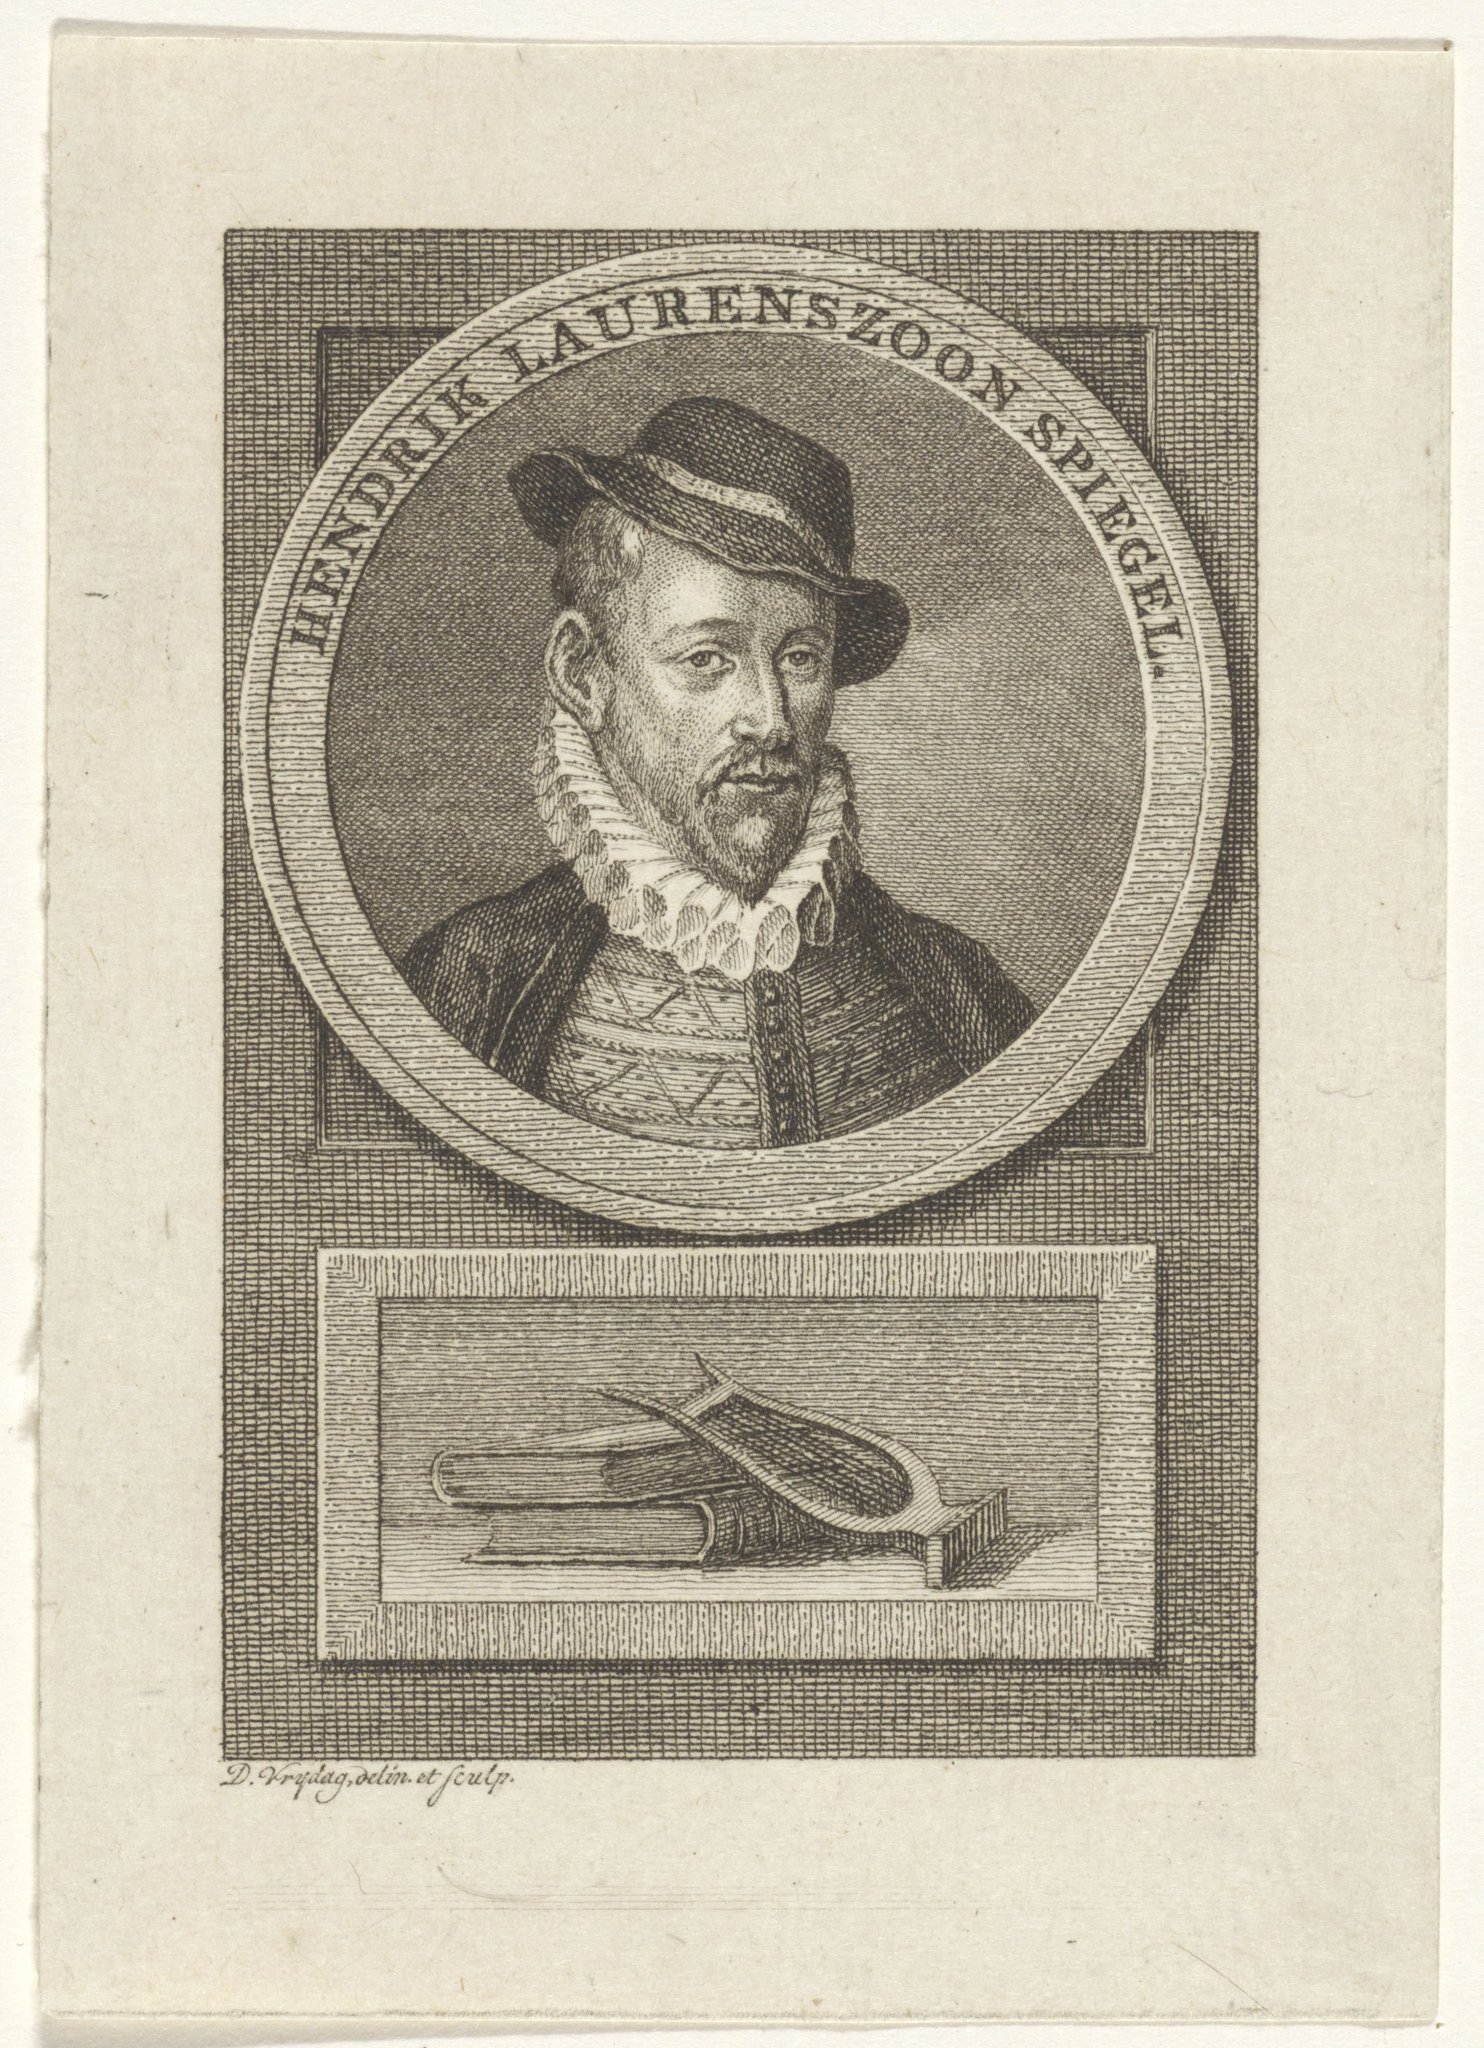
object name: print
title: Portret van Hendrick Laurensz. Spiegel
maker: daniël vrijdag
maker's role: draughtsman, print maker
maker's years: 1765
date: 1783-1795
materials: paper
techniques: engraving, etching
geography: amsterdam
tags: amsterdam, hendrick laurensz. spieghel, lyre, cithara, psaltery, book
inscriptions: collector's mark: Lugt 2228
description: Prent gebruikt in: Fokke, Jan. Geschiedenissen der Vereenigde Nederlanden voor de vaderlandsche jeugd Ie-XXVste deel. Amsterdam: Johannes Allart, 1783-1795.